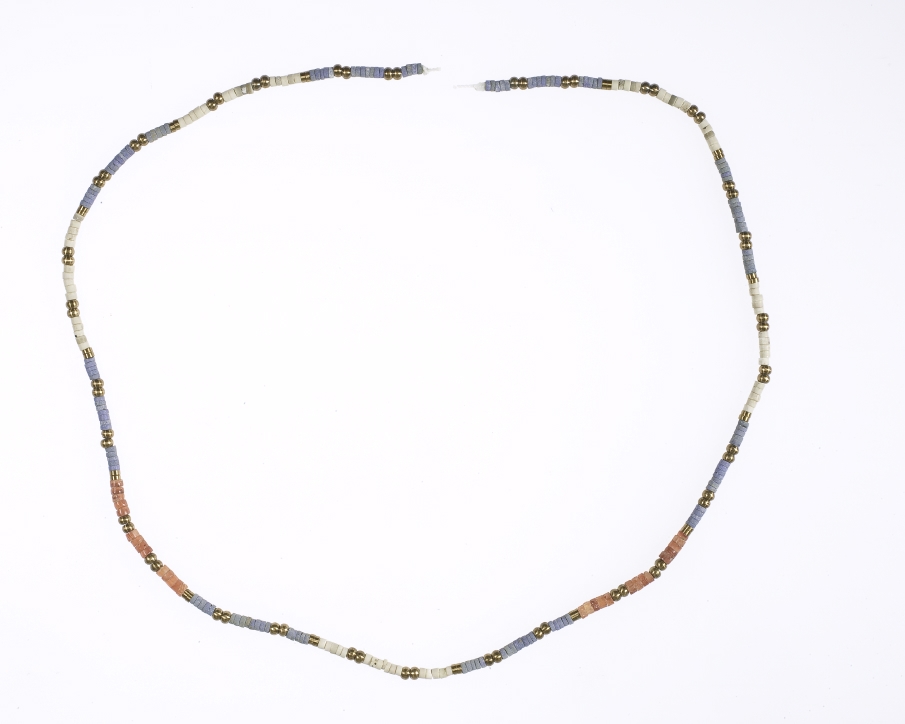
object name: bead, string, hepy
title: String of ring and ball beads of Hepy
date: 1950-1885 BCE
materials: bronze, gemstone, paste, stone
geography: egypt